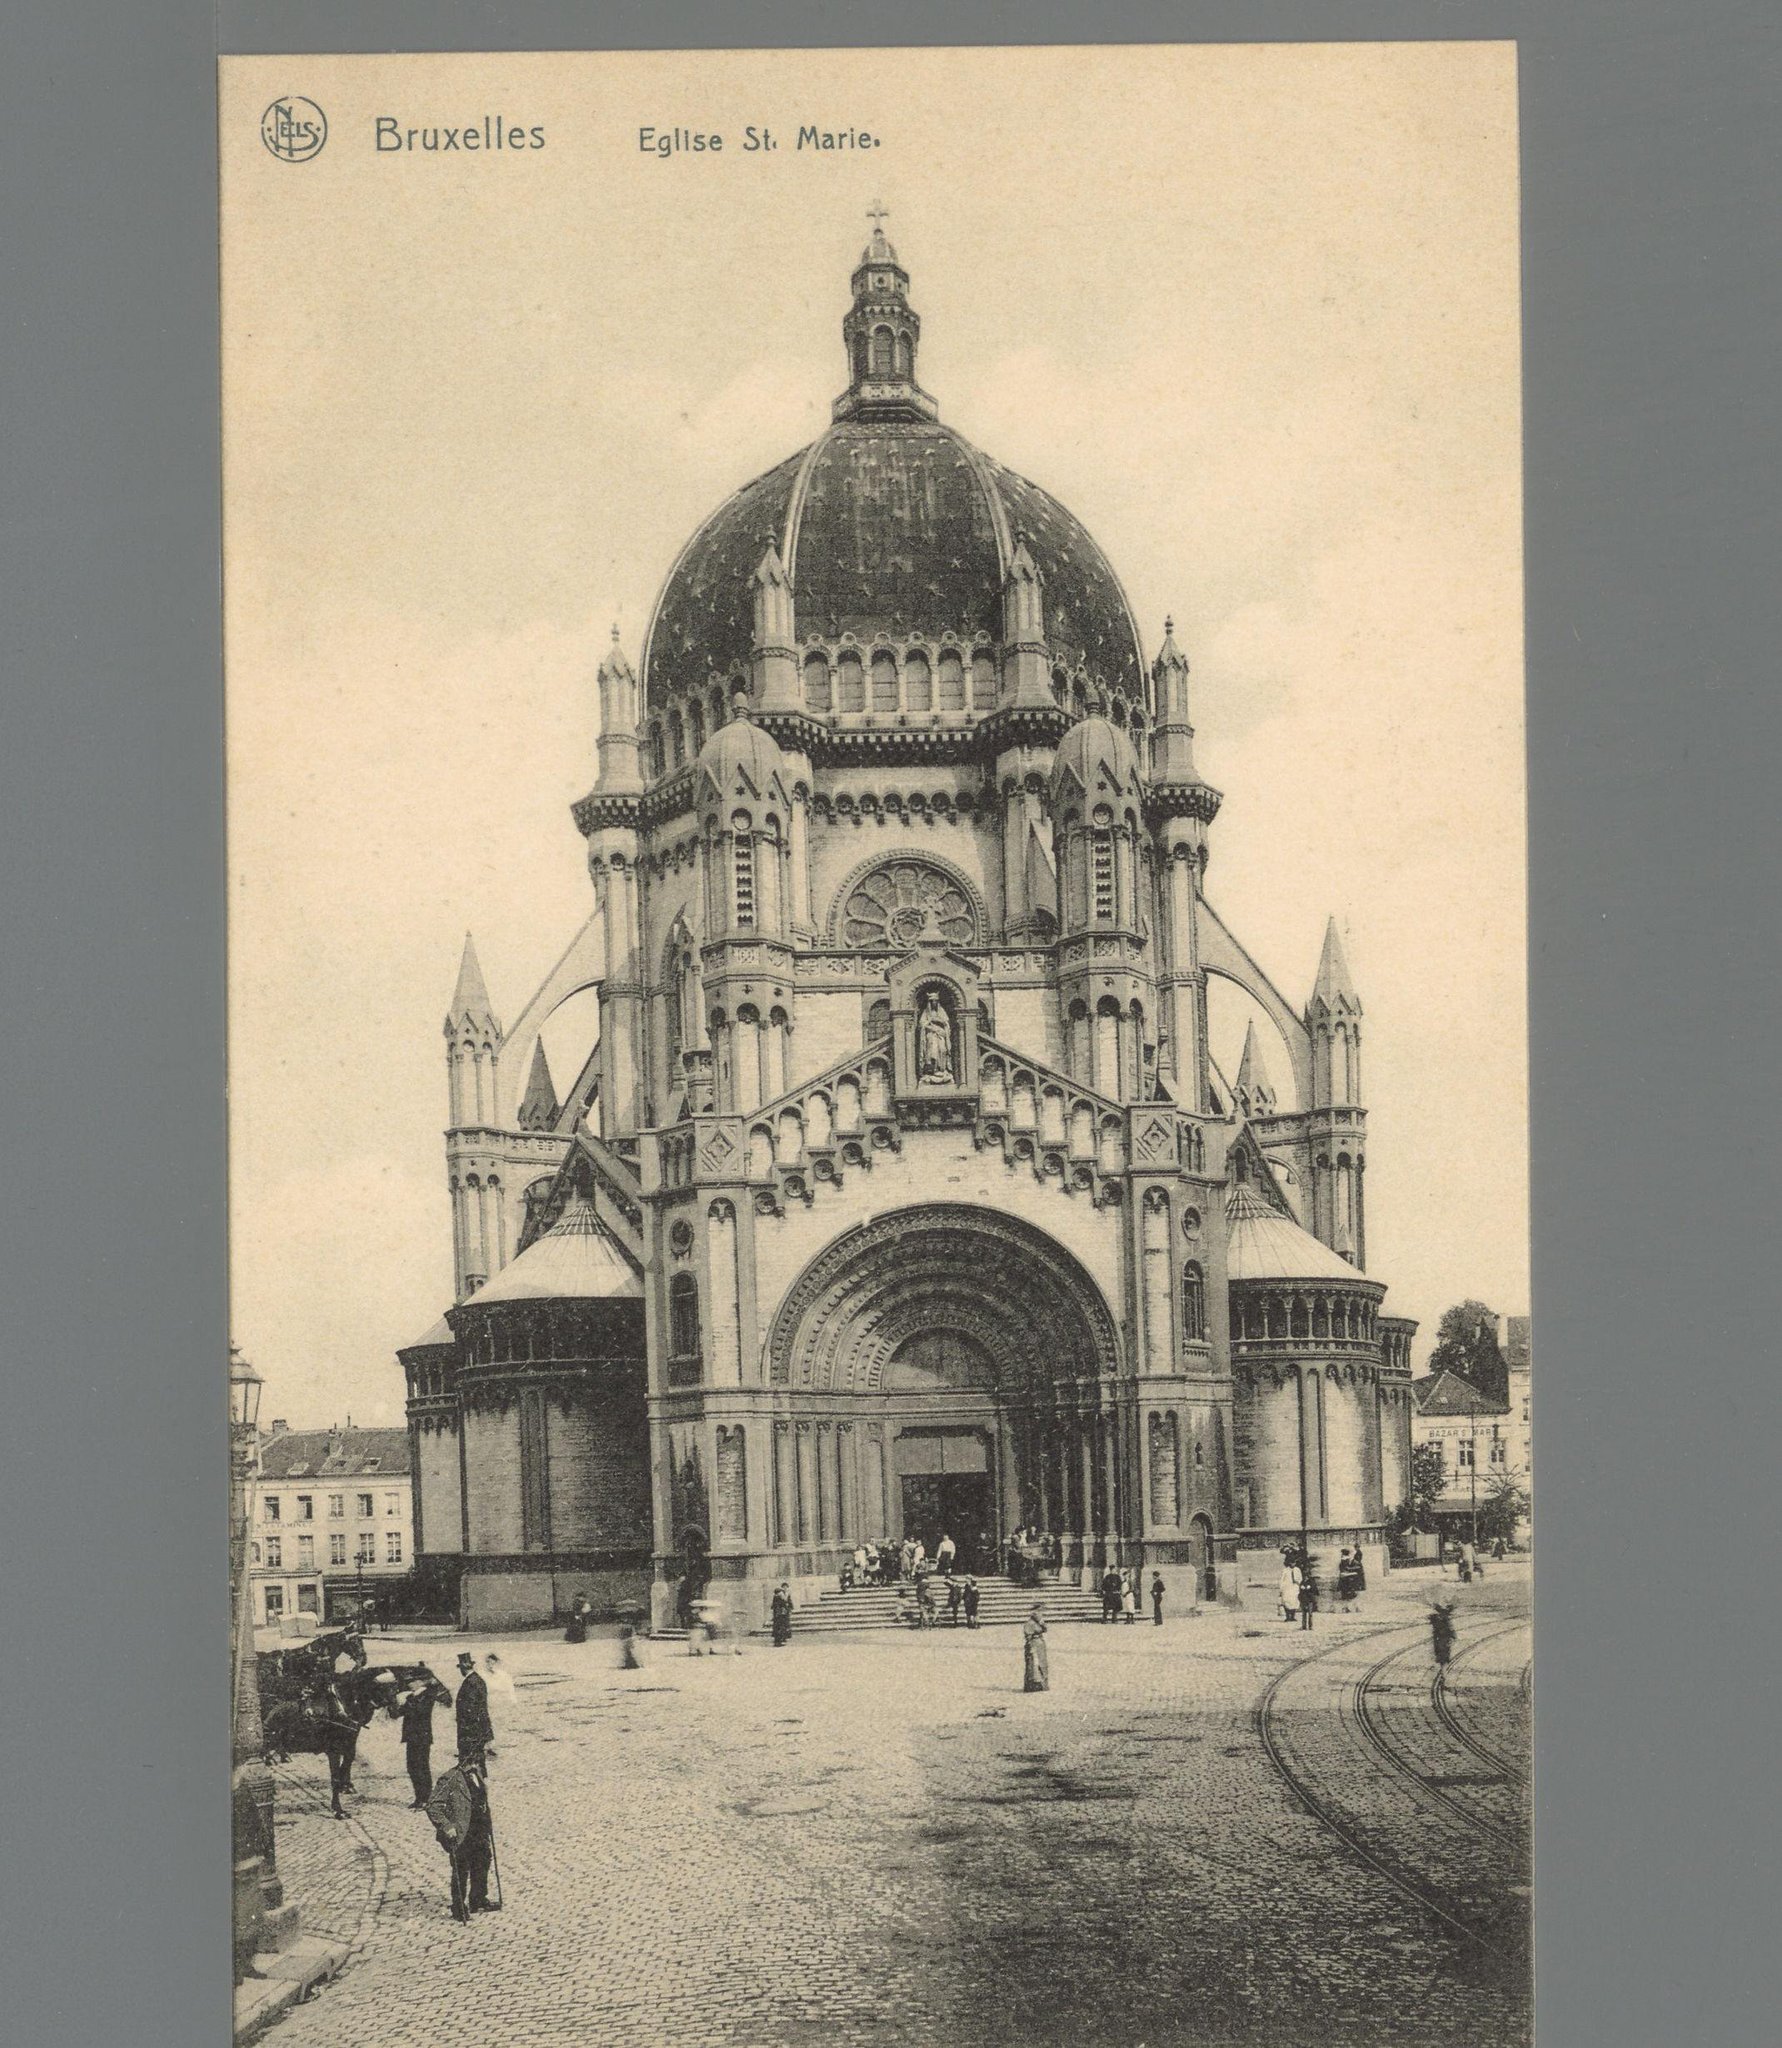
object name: ansichtkaart, prentbriefkaart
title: Bruxelles. Eglise St. Marie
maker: Anonymous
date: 1907-1913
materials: cardboard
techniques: photograph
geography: brussels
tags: church (exterior), square, place, circus, etc. (+ city(-scape) with figures, staffage)